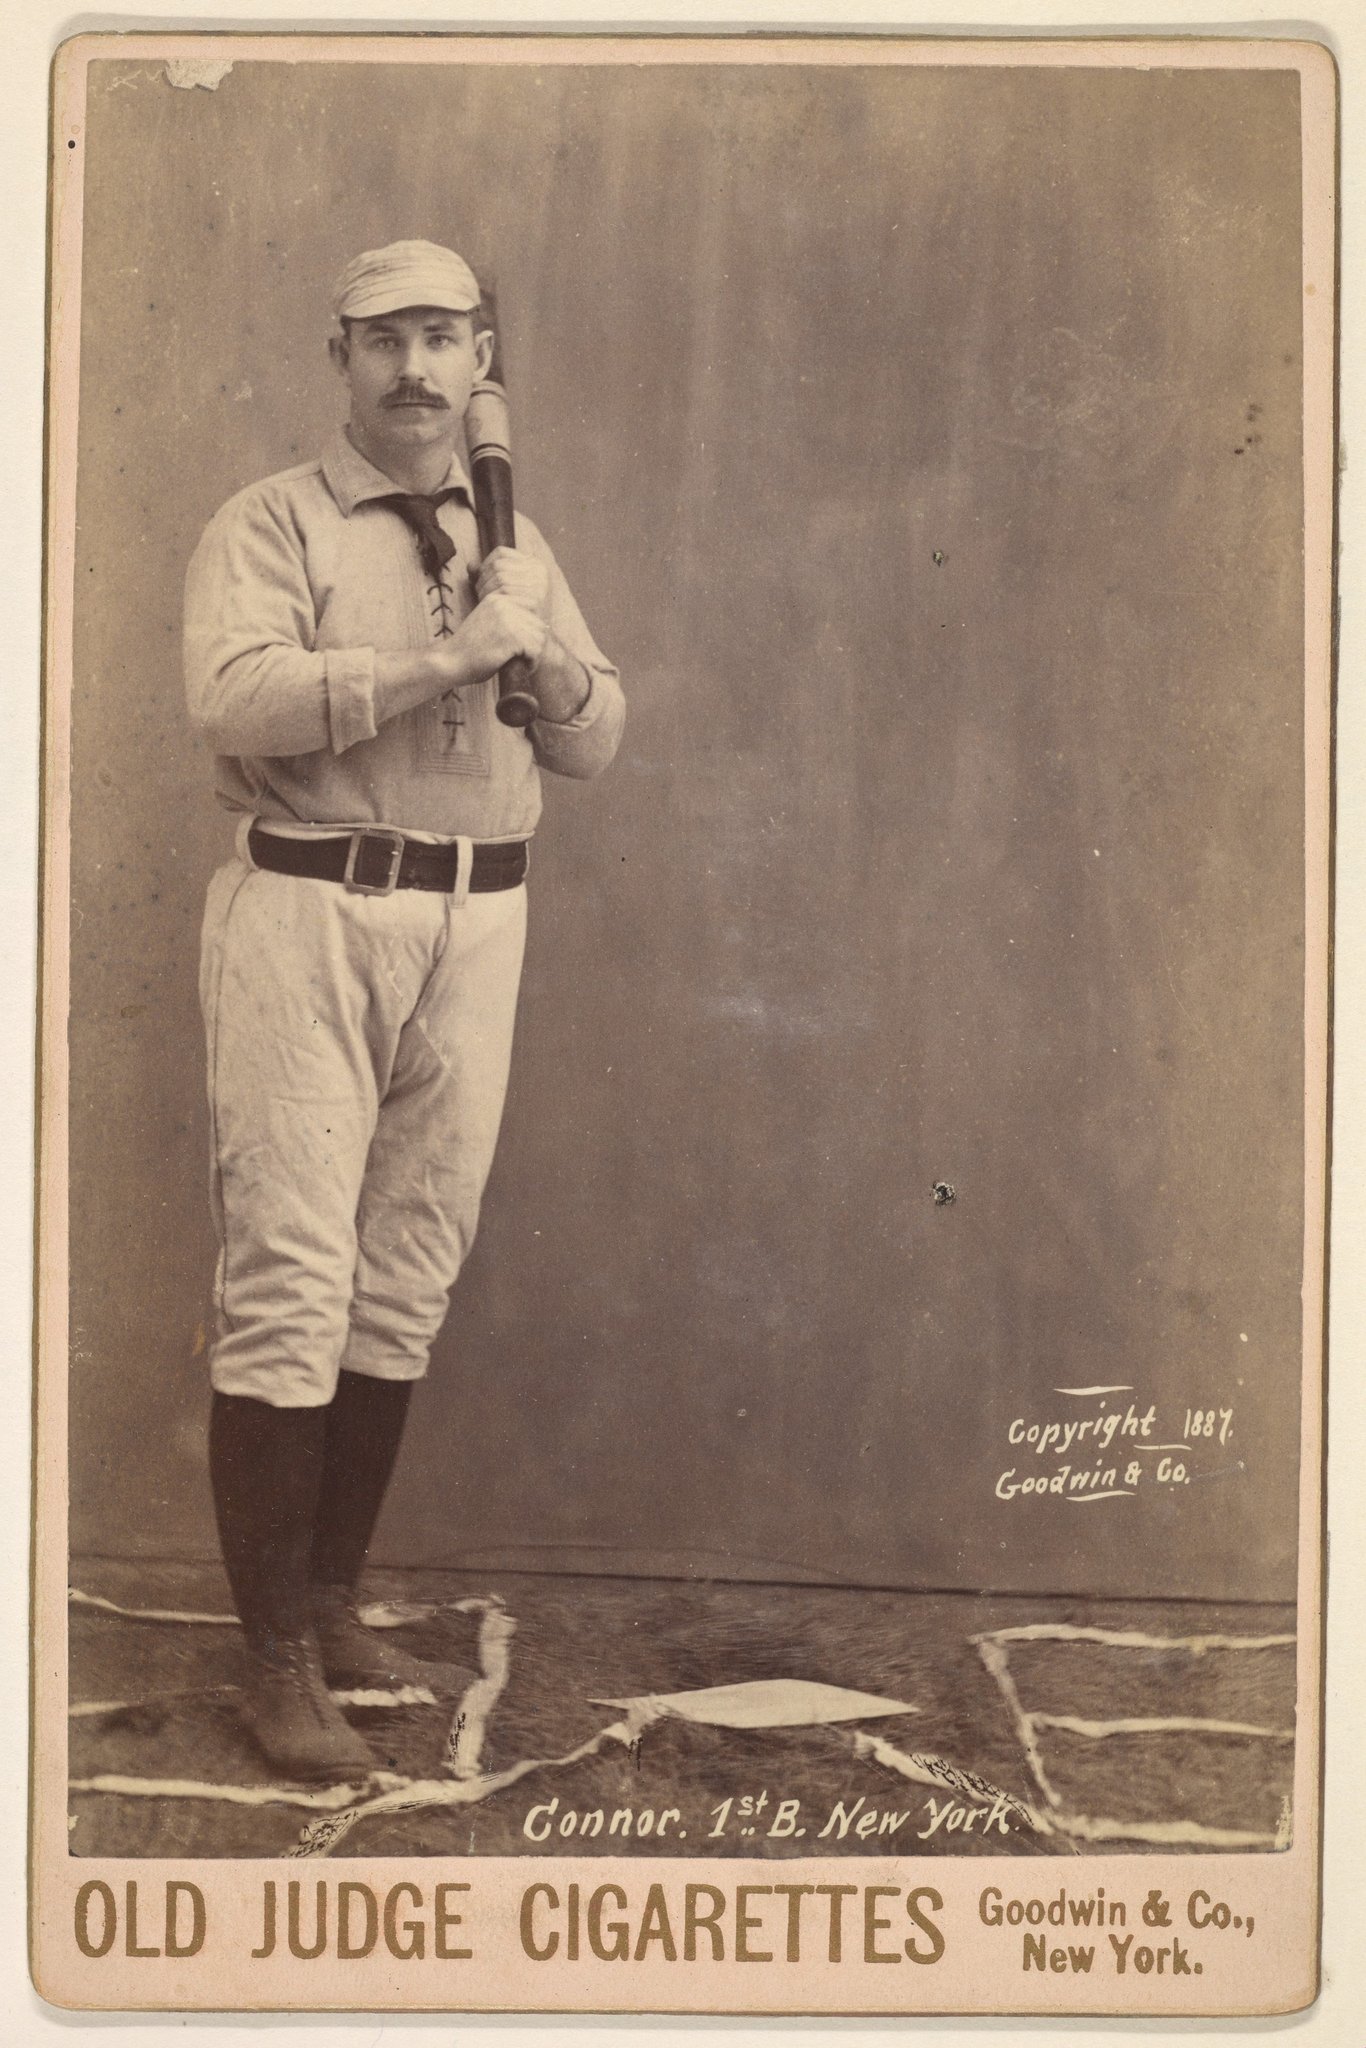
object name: baseball card, photograph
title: Connor, 1st Base, New York, from the series Old Judge Cigarettes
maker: goodwin & company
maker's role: publisher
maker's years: 1850-1950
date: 1887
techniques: albumen silver print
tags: men,portraits,baseball,athletes